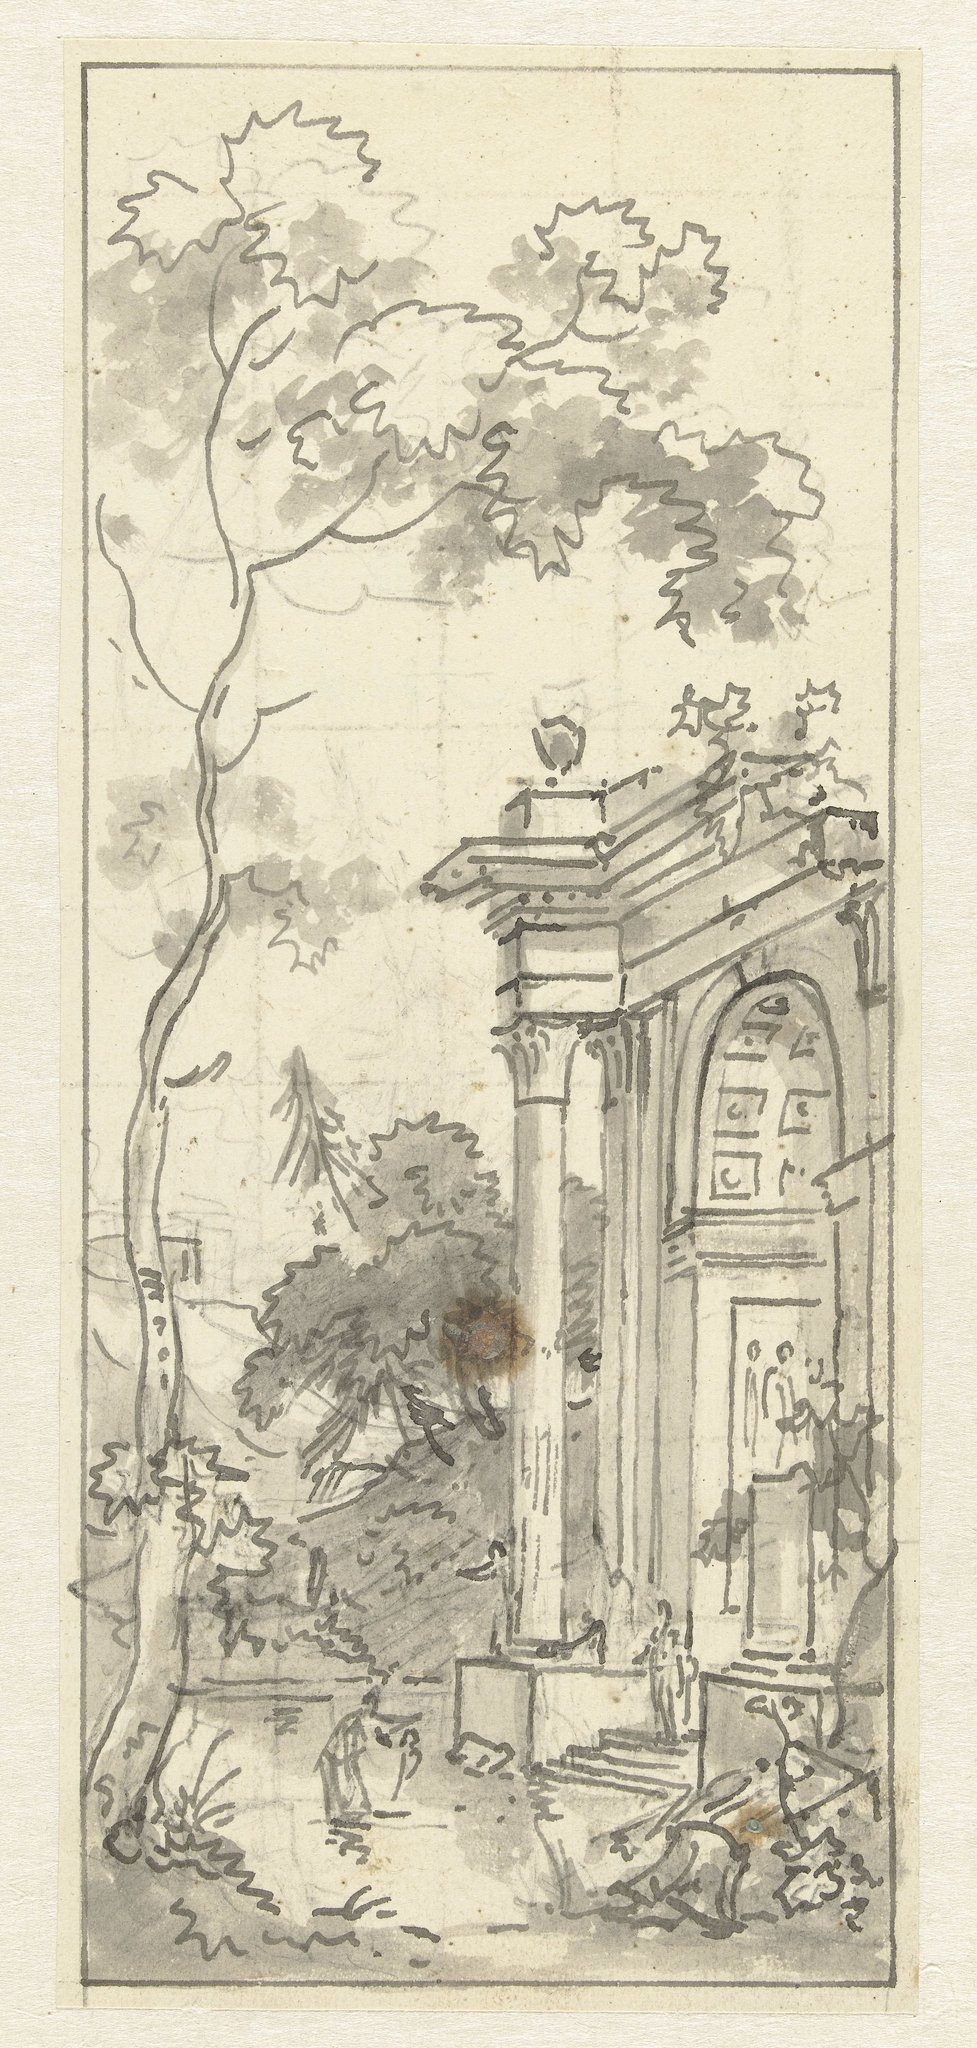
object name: drawing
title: Ontwerp voor behangselschildering voor T.A. van Iddekinge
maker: jurriaan andriessen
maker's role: draughtsman, painter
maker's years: 1742-1819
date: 1752-1819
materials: chalk, graphite, ink, paper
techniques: brush, pen, drawing